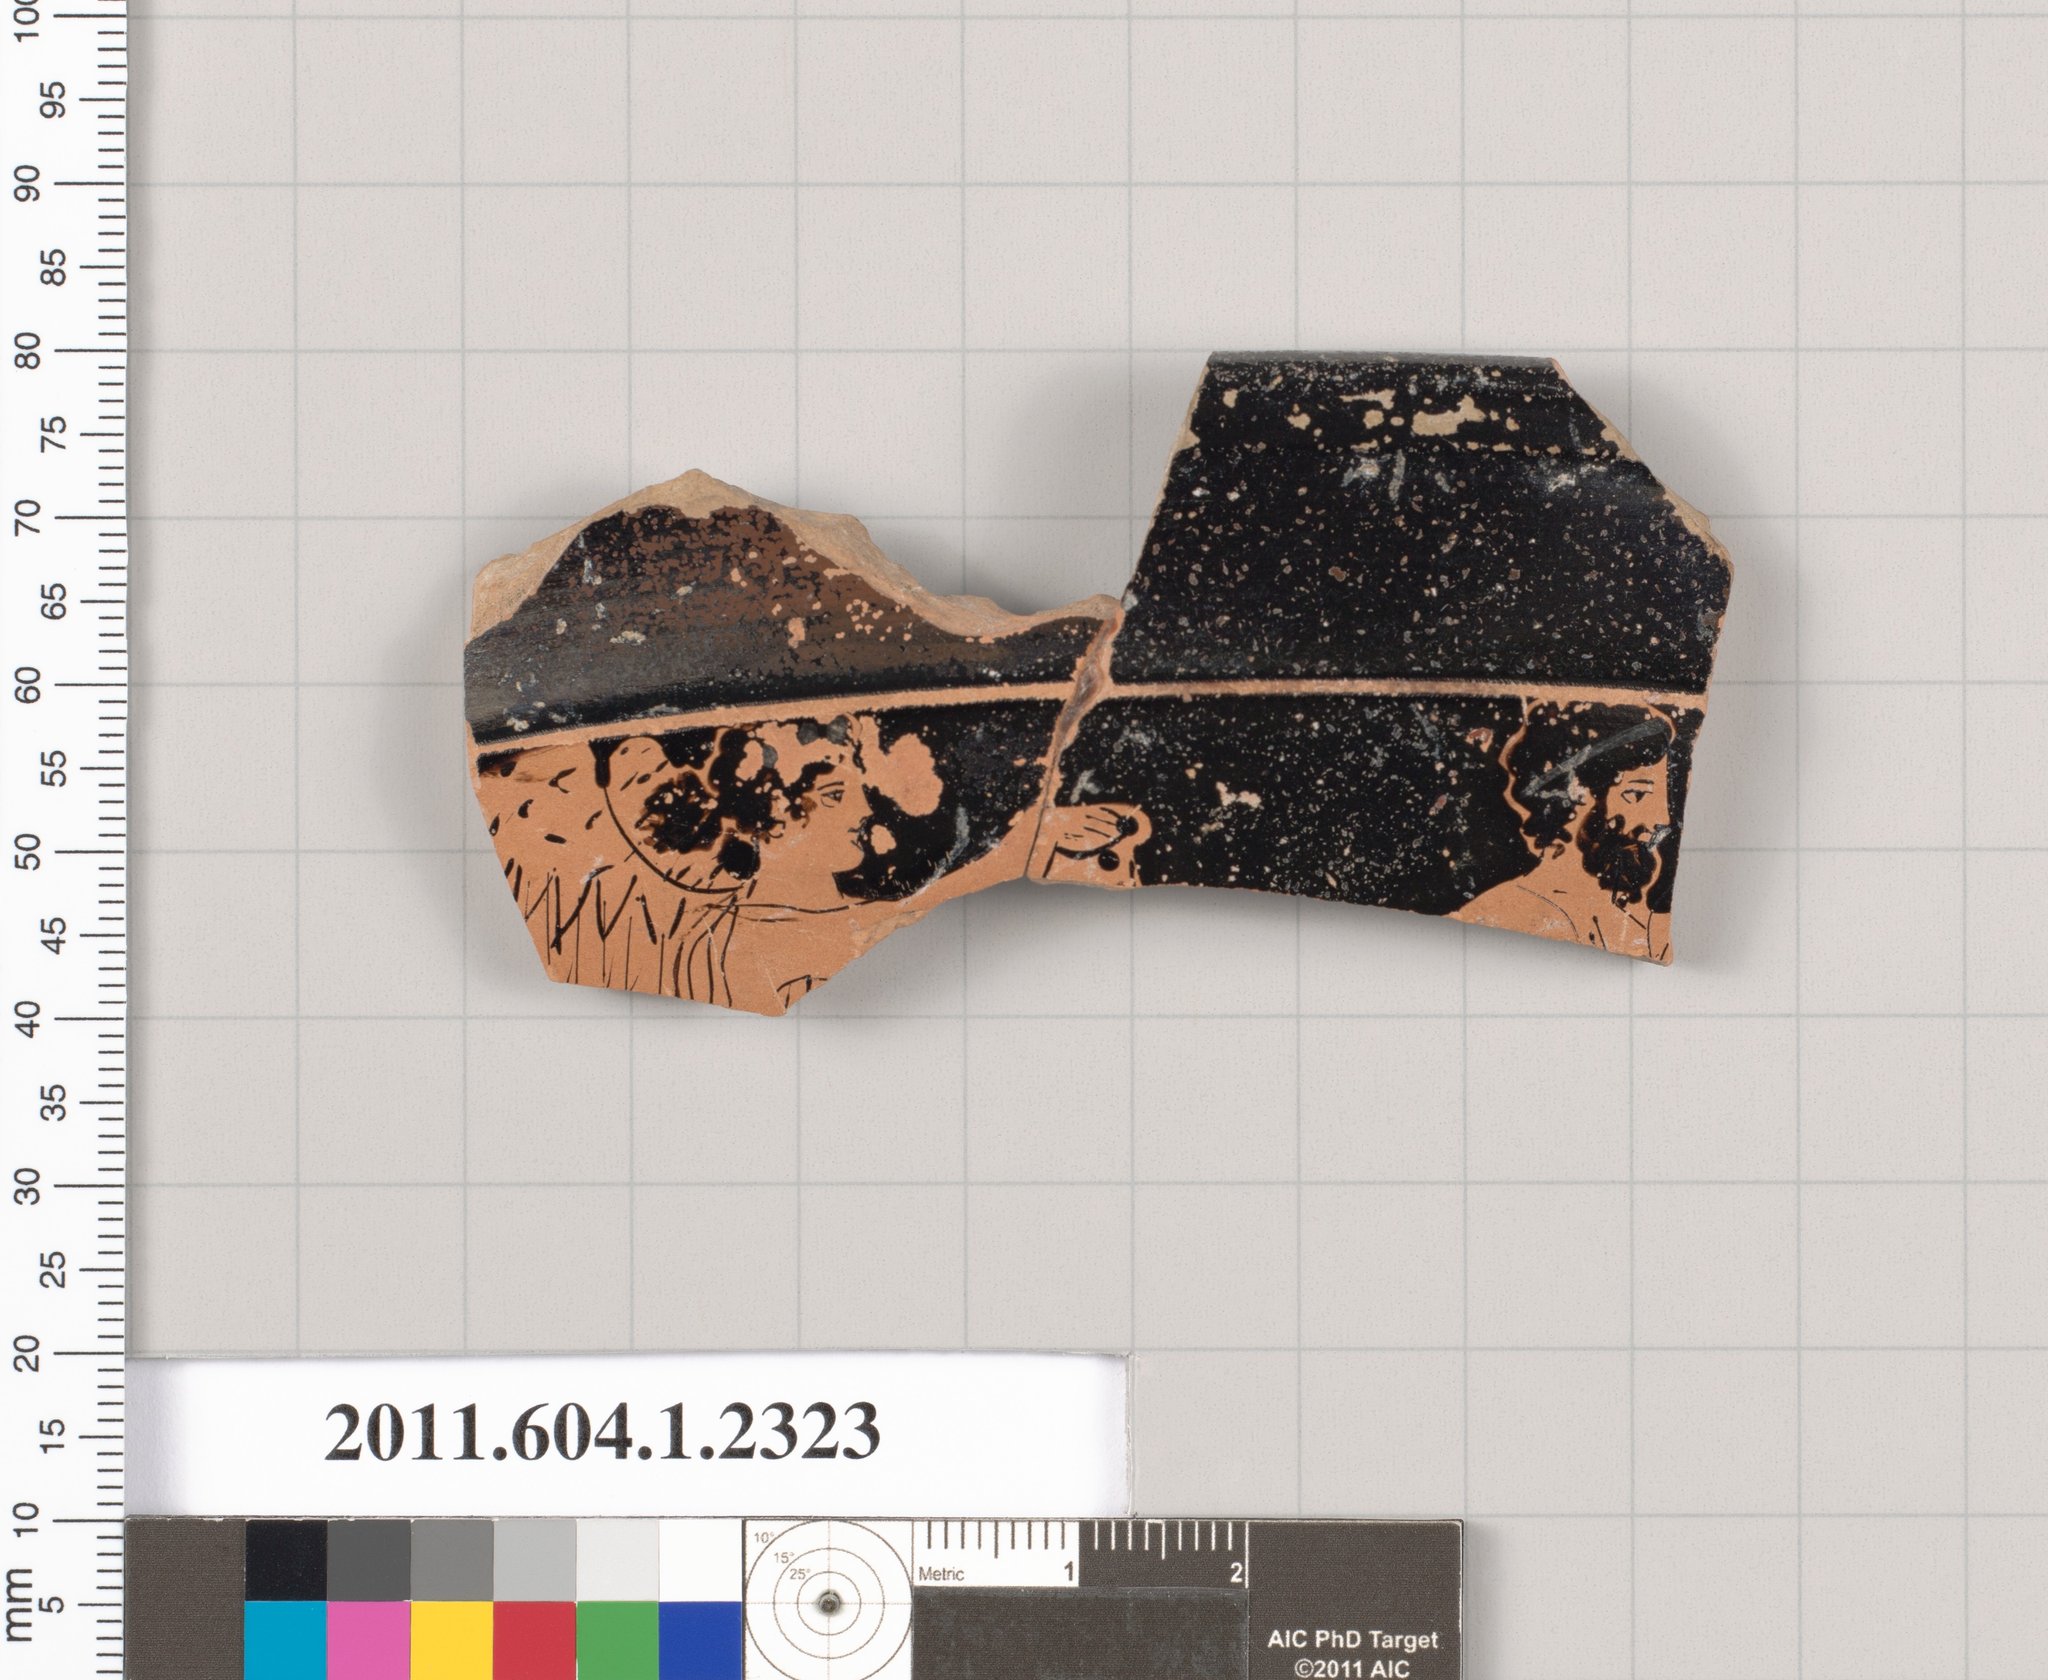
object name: kylix fragment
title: Terracotta rim fragment of a kylix (drinking cup)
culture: greek, attic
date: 467-435 BCE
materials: terracotta